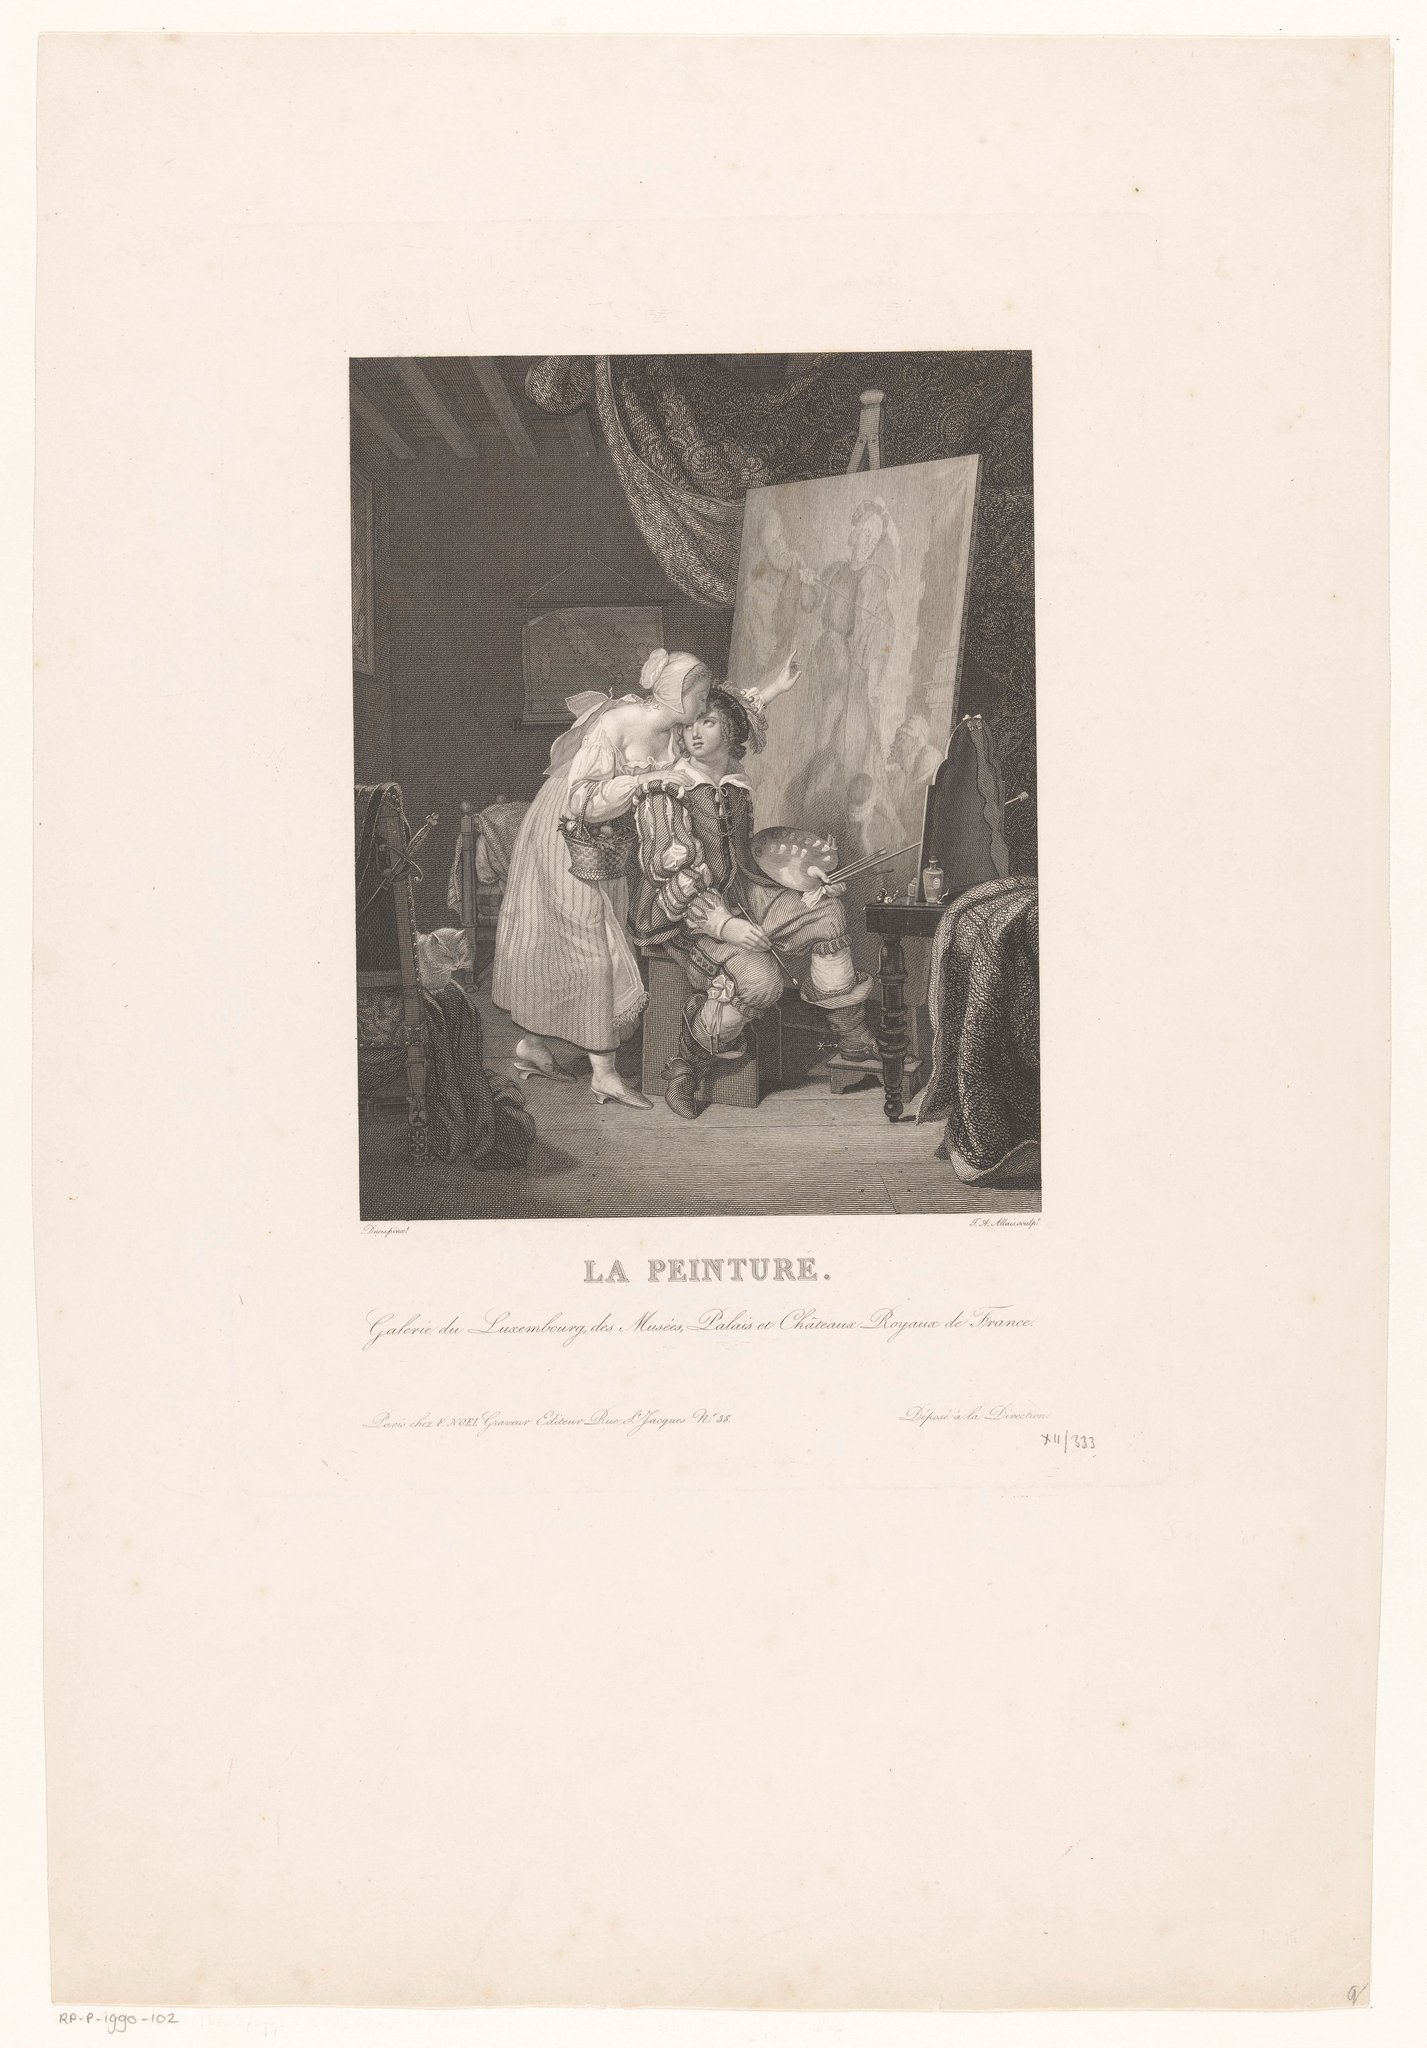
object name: print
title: Jonge vrouw en een schilder in een atelier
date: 1820-1821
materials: paper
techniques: engraving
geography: france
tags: antwerp, london, painter, print maker, draughtsman, anthony van dyck, painter at work, in his studio, standing figure - aa - female human figure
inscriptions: : ‘Déposé à la Direction’, collector's mark: Lugt 2228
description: Het schilderij van Louis Ducis waarnaar deze staalgravure is gemaakt dateert uit 1819 en is getiteld "Van Dyck peignant son premier tableau". Deze titel wordt ook in oeuvrecatalogi met werk van Allais gehanteerd.